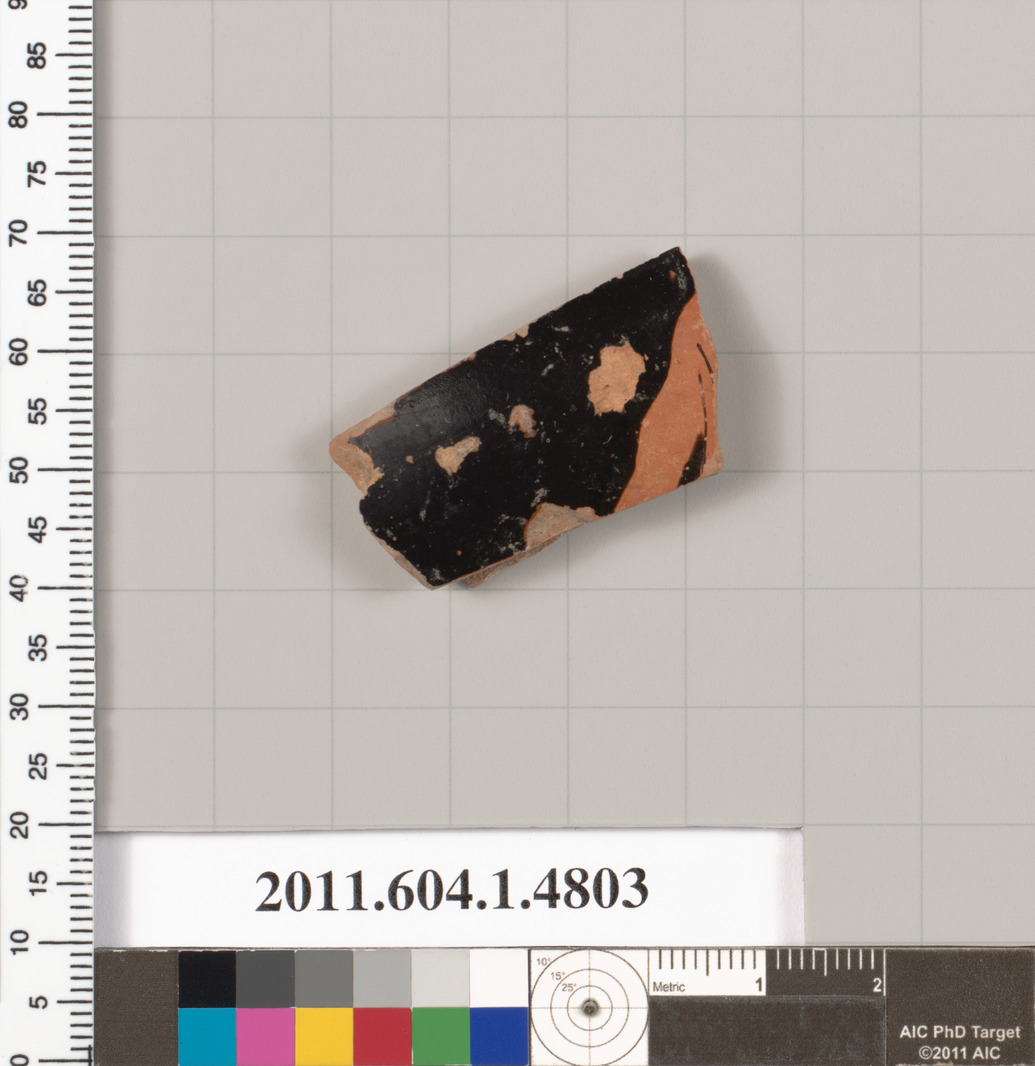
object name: kylix fragment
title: Terracotta fragment of a kylix (drinking cup)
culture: greek, attic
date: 460-450 BCE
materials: terracotta